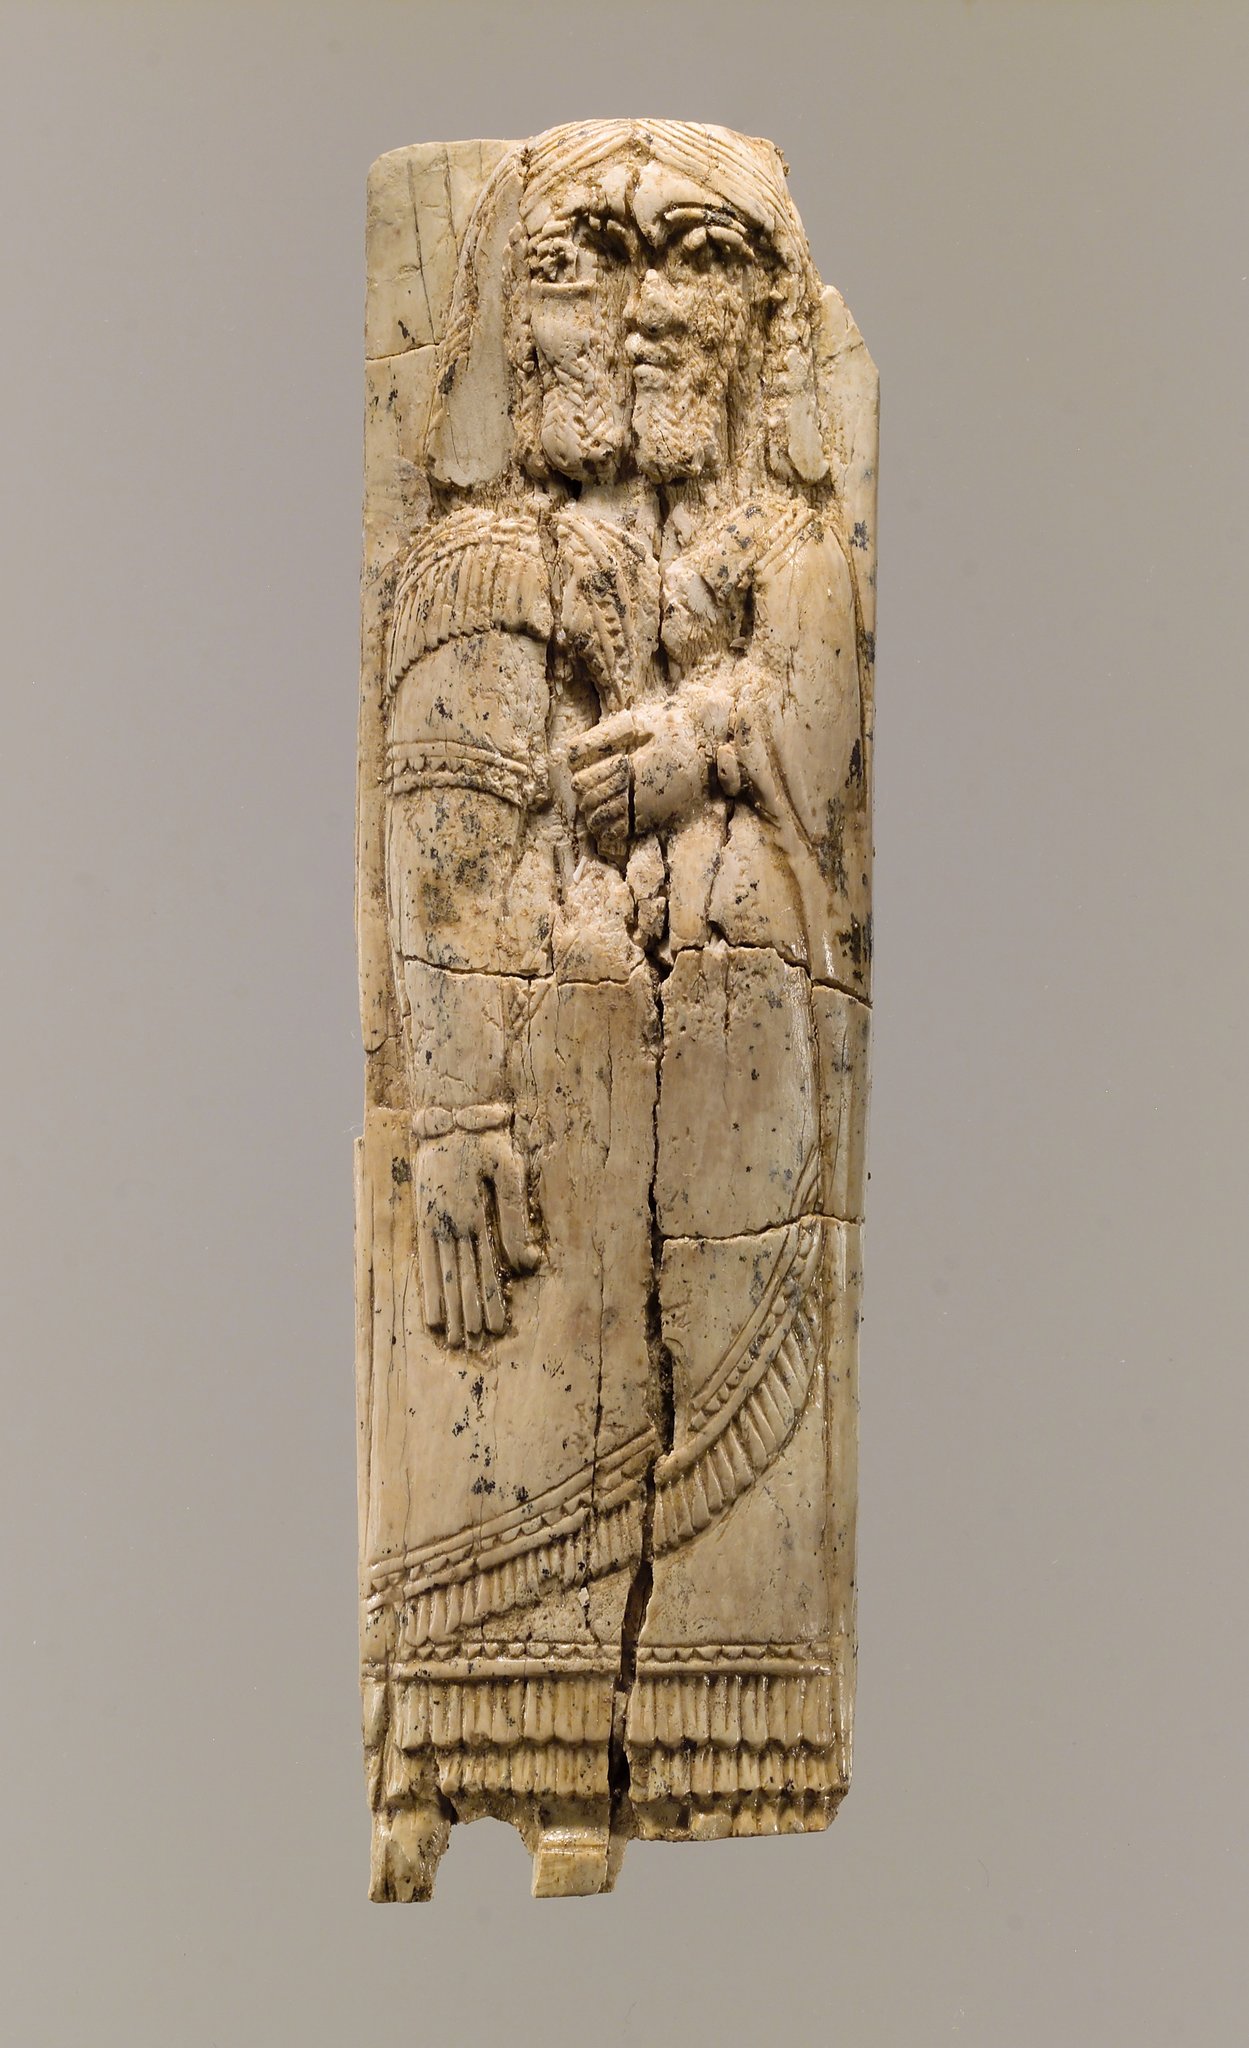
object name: relief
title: Furniture plaque with figure in relief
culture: assyrian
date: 900-701 BCE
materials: ivory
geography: mesopotamia